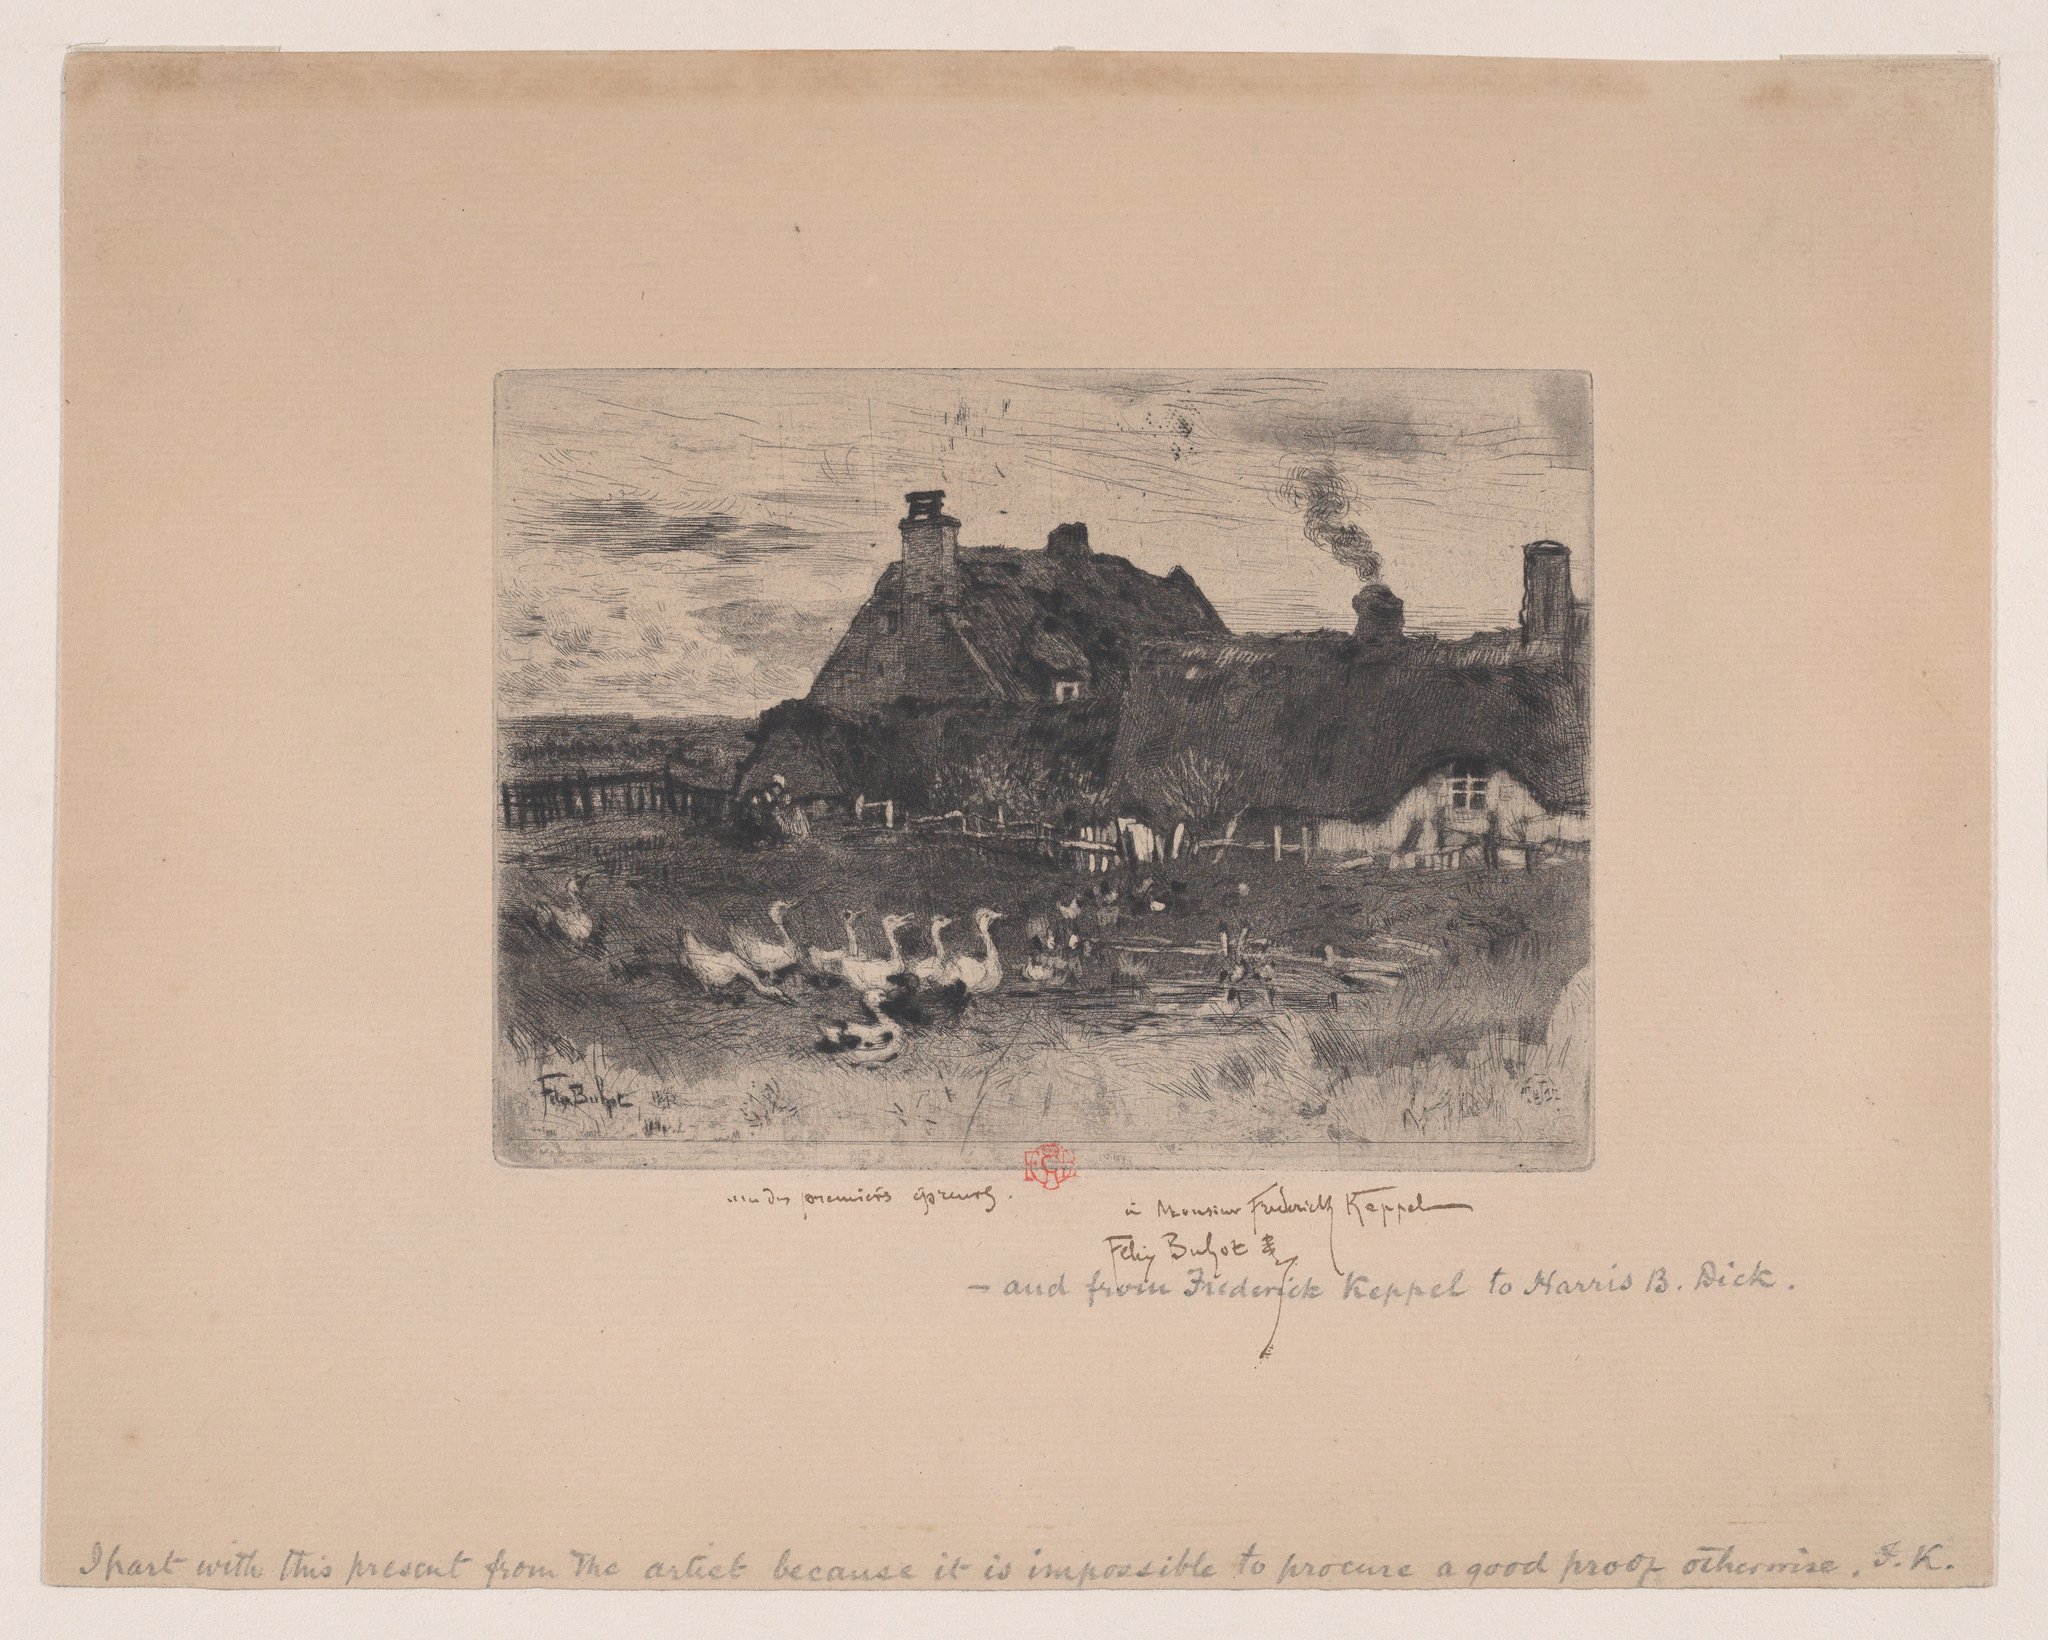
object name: print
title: Small Thatched Cottages (Les Petites Chaumières)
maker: félix-hilaire buhot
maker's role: artist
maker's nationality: french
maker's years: 1847-1898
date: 1878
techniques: aquatint, burnishing, drypoint, etching, roulette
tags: ducks,houses